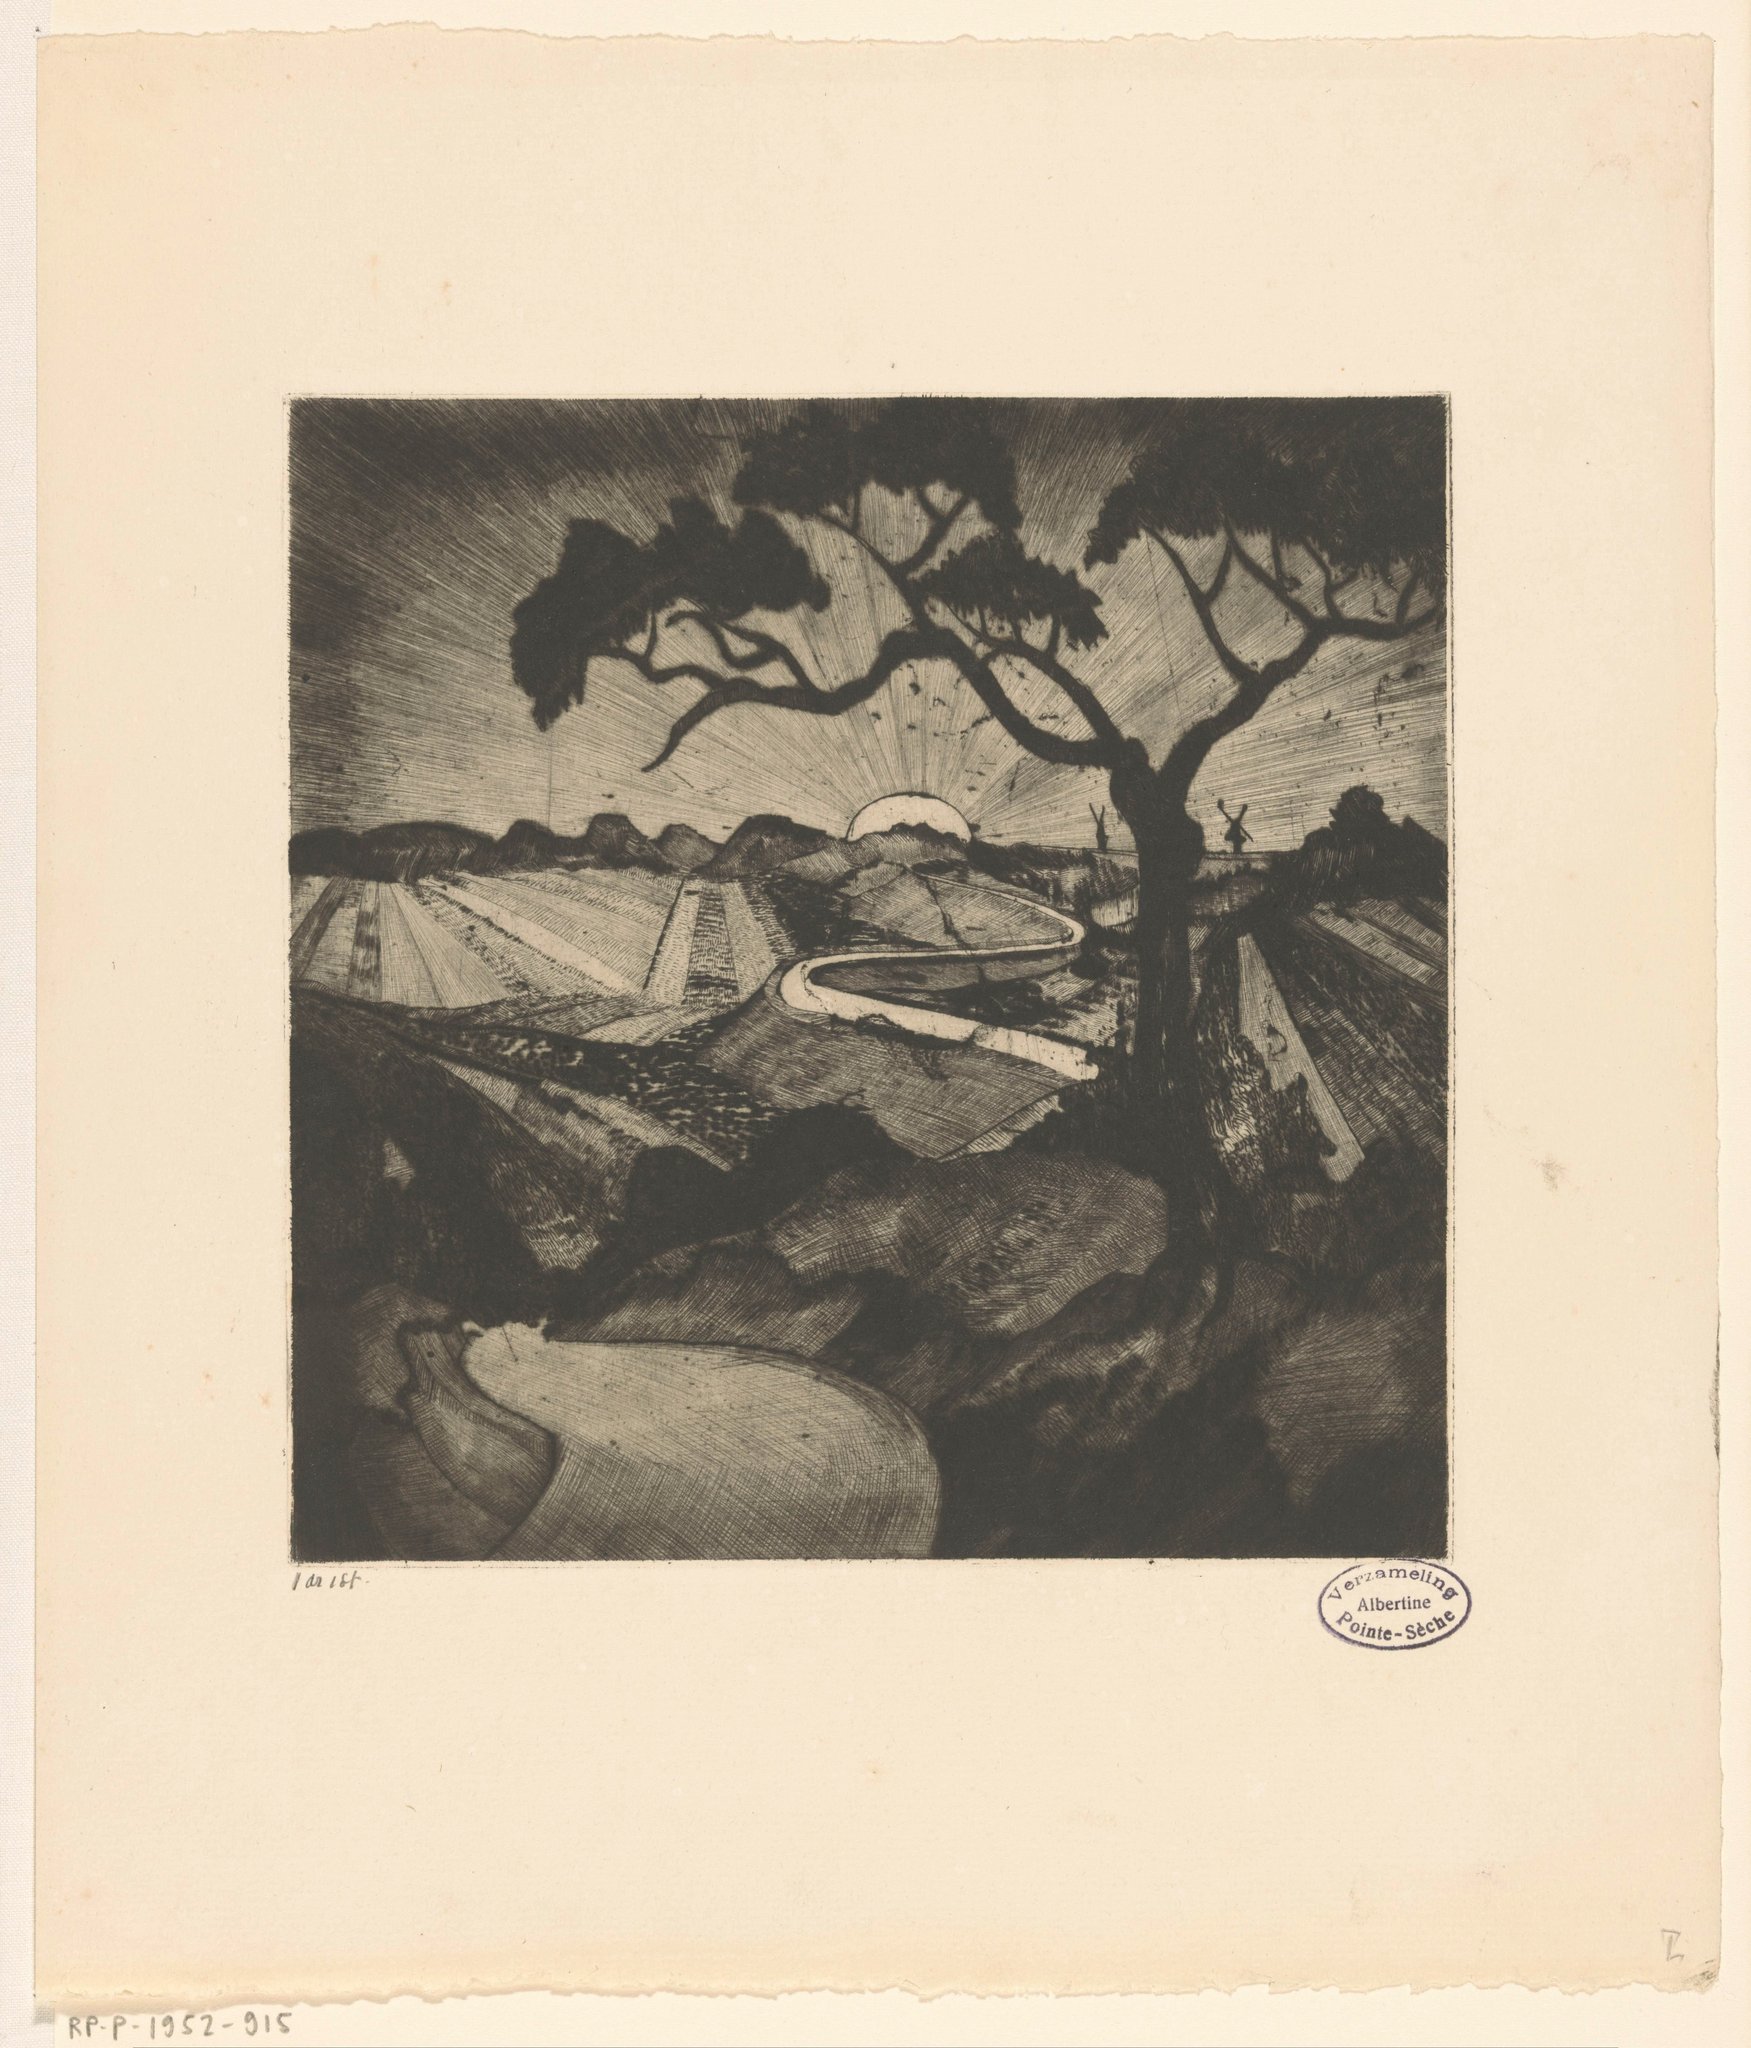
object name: print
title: Le Soleil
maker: lodewijk schelfhout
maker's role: draughtsman, print maker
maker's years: 1881-1943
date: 1918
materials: paper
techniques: drypoint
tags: low hill country, trees, sun as celestial body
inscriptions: collector's mark: Lugt 2760, collector's mark: Lugt 5i, collector's mark: Lugt 2228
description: De opgaande of ondergaande zon boven een heuvellandschap met twee molens. Op de voorgrond een boom.